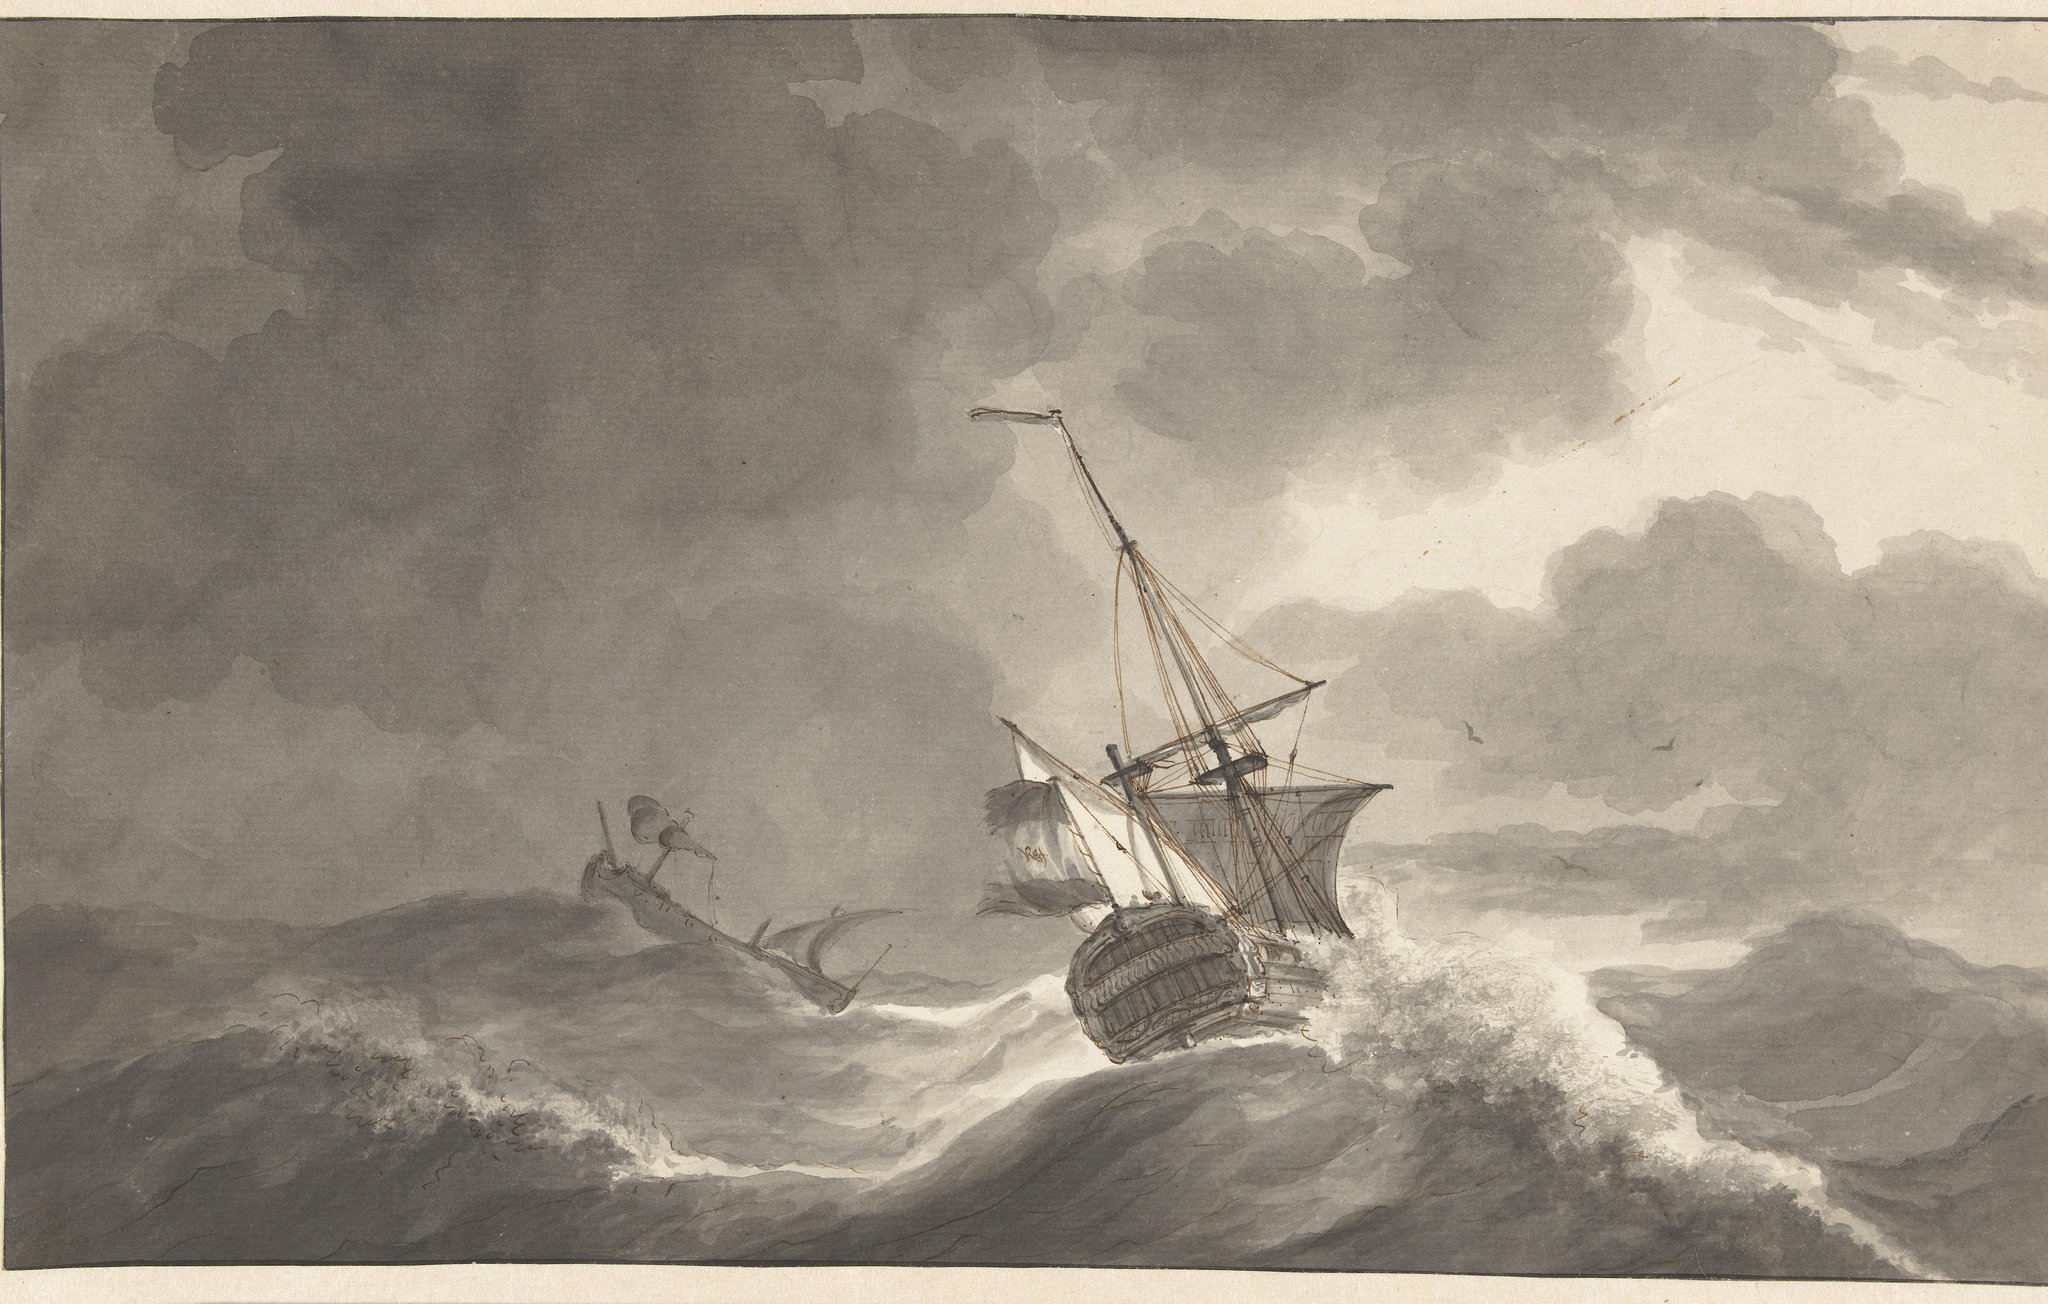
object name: drawing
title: Twee schepen op zee bij storm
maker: hendrik kobell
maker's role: draughtsman, painter, print maker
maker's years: 1751-1779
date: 1761-1779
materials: chalk, ink, paper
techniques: brush, pen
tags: sailing-ship, sailing-boat, sea (seascape), storm at sea